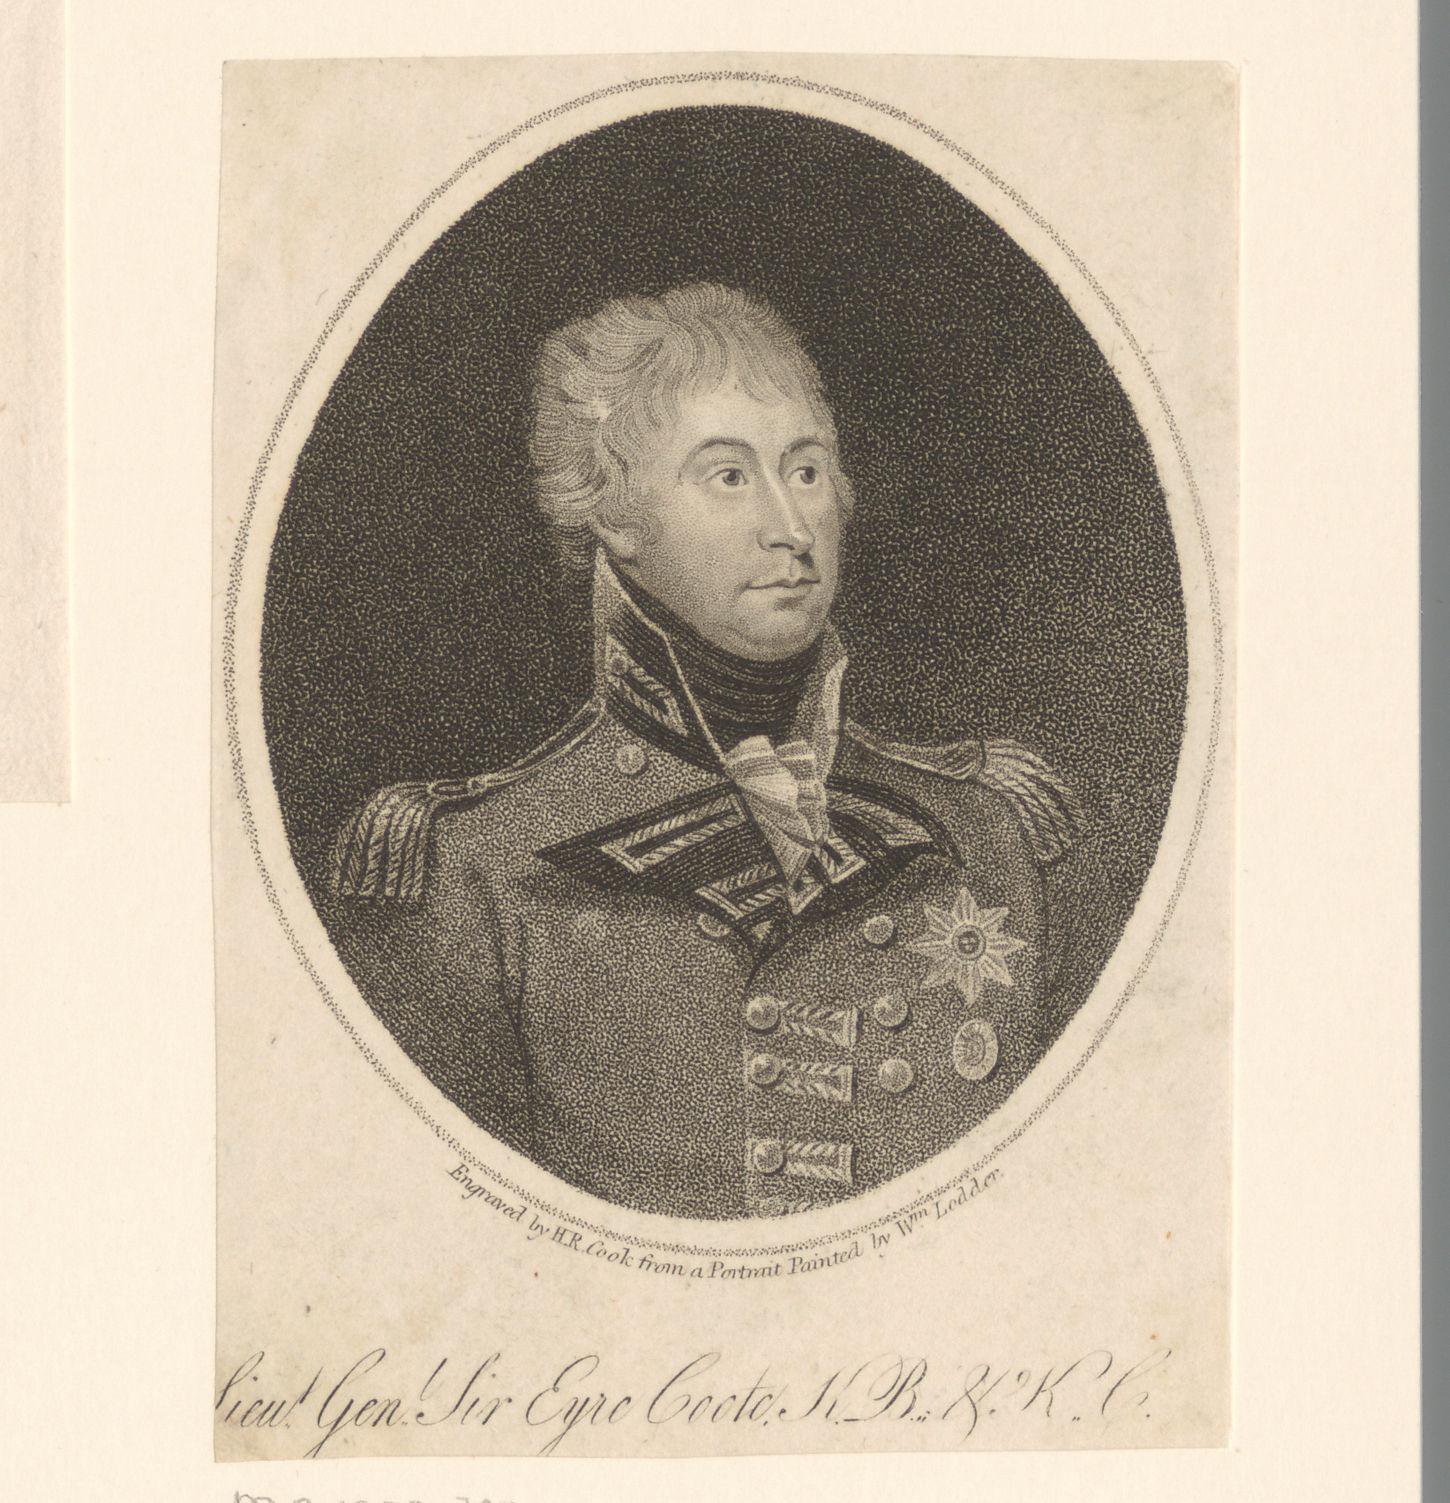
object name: print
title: Portret van Eyre Coote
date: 1804-1849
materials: paper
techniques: stippling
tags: politician, commander-in-chief, general, marshal, historical persons, politician, e.g. party leader, medals and other marks of military honour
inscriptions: collector's mark: Lugt 2228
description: Prent gebruikt in: European Magazine, 1810.